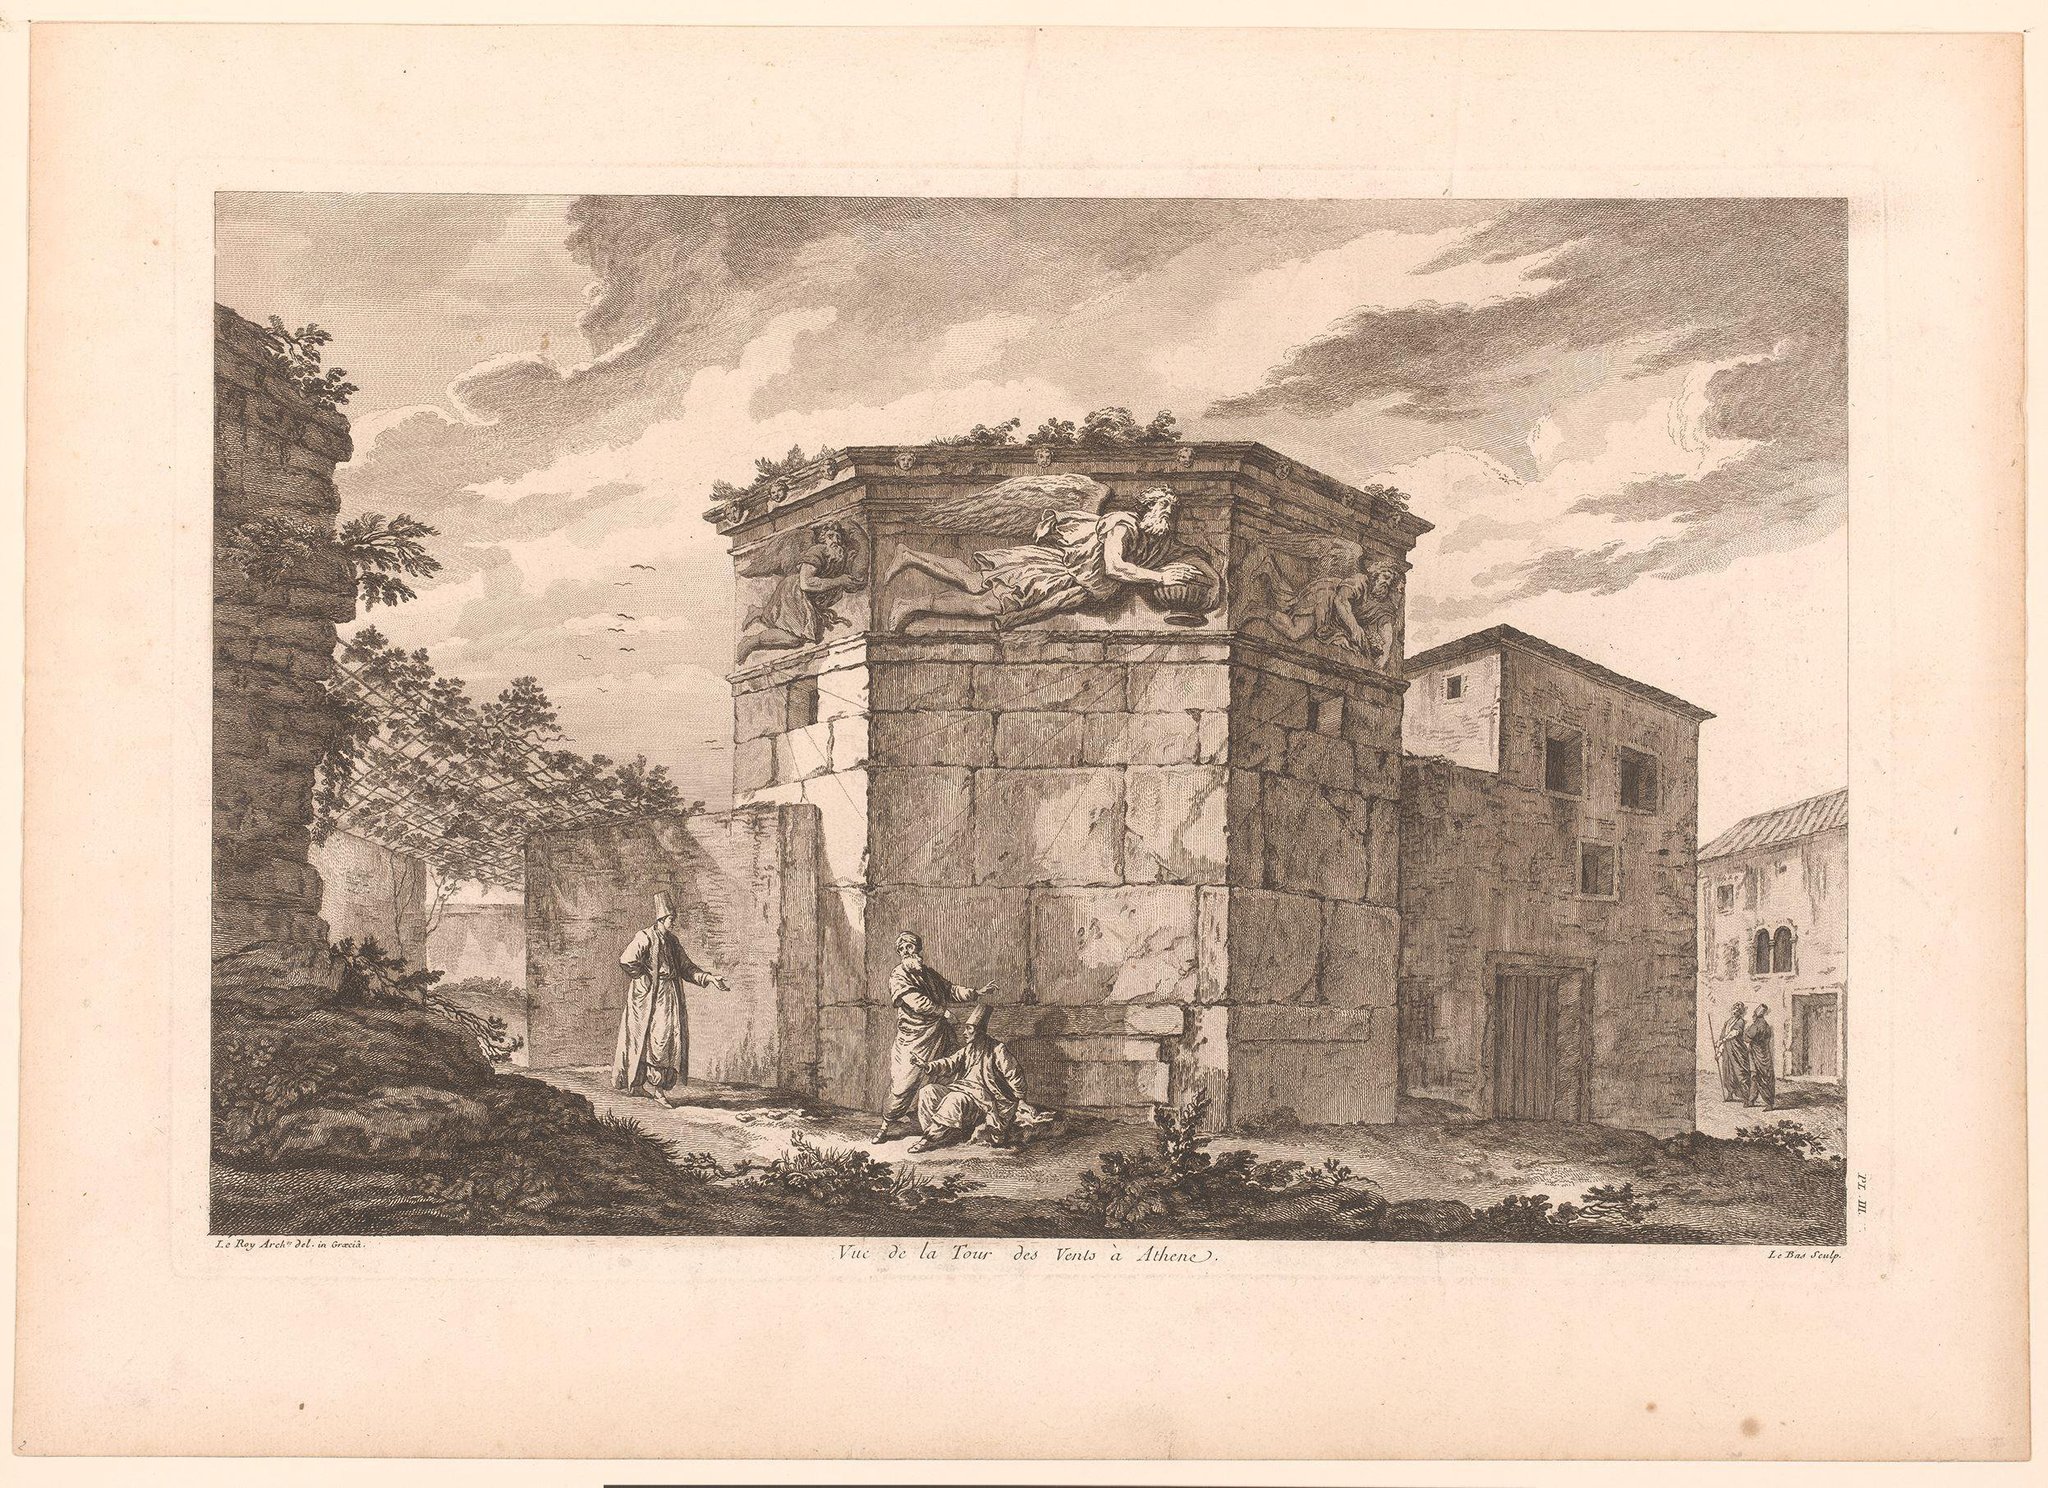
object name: book illustration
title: Gezicht op de Toren van de winden (Horologium van Andronicus van Cyrrhus)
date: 1758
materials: paper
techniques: etching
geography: paris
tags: tower, clock tower ~ monumental adornment, ruin of a building ~ architecture, monumental adornments (in city)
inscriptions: collector's mark: Lugt 2228, collector's mark: Lugt 2228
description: Prent uit: Le Roy, Julien. Ruines des plus beaux monuments de la Grêce. Parijs: Guérin & de La Tour, 1758. Dit betreft plaat III.